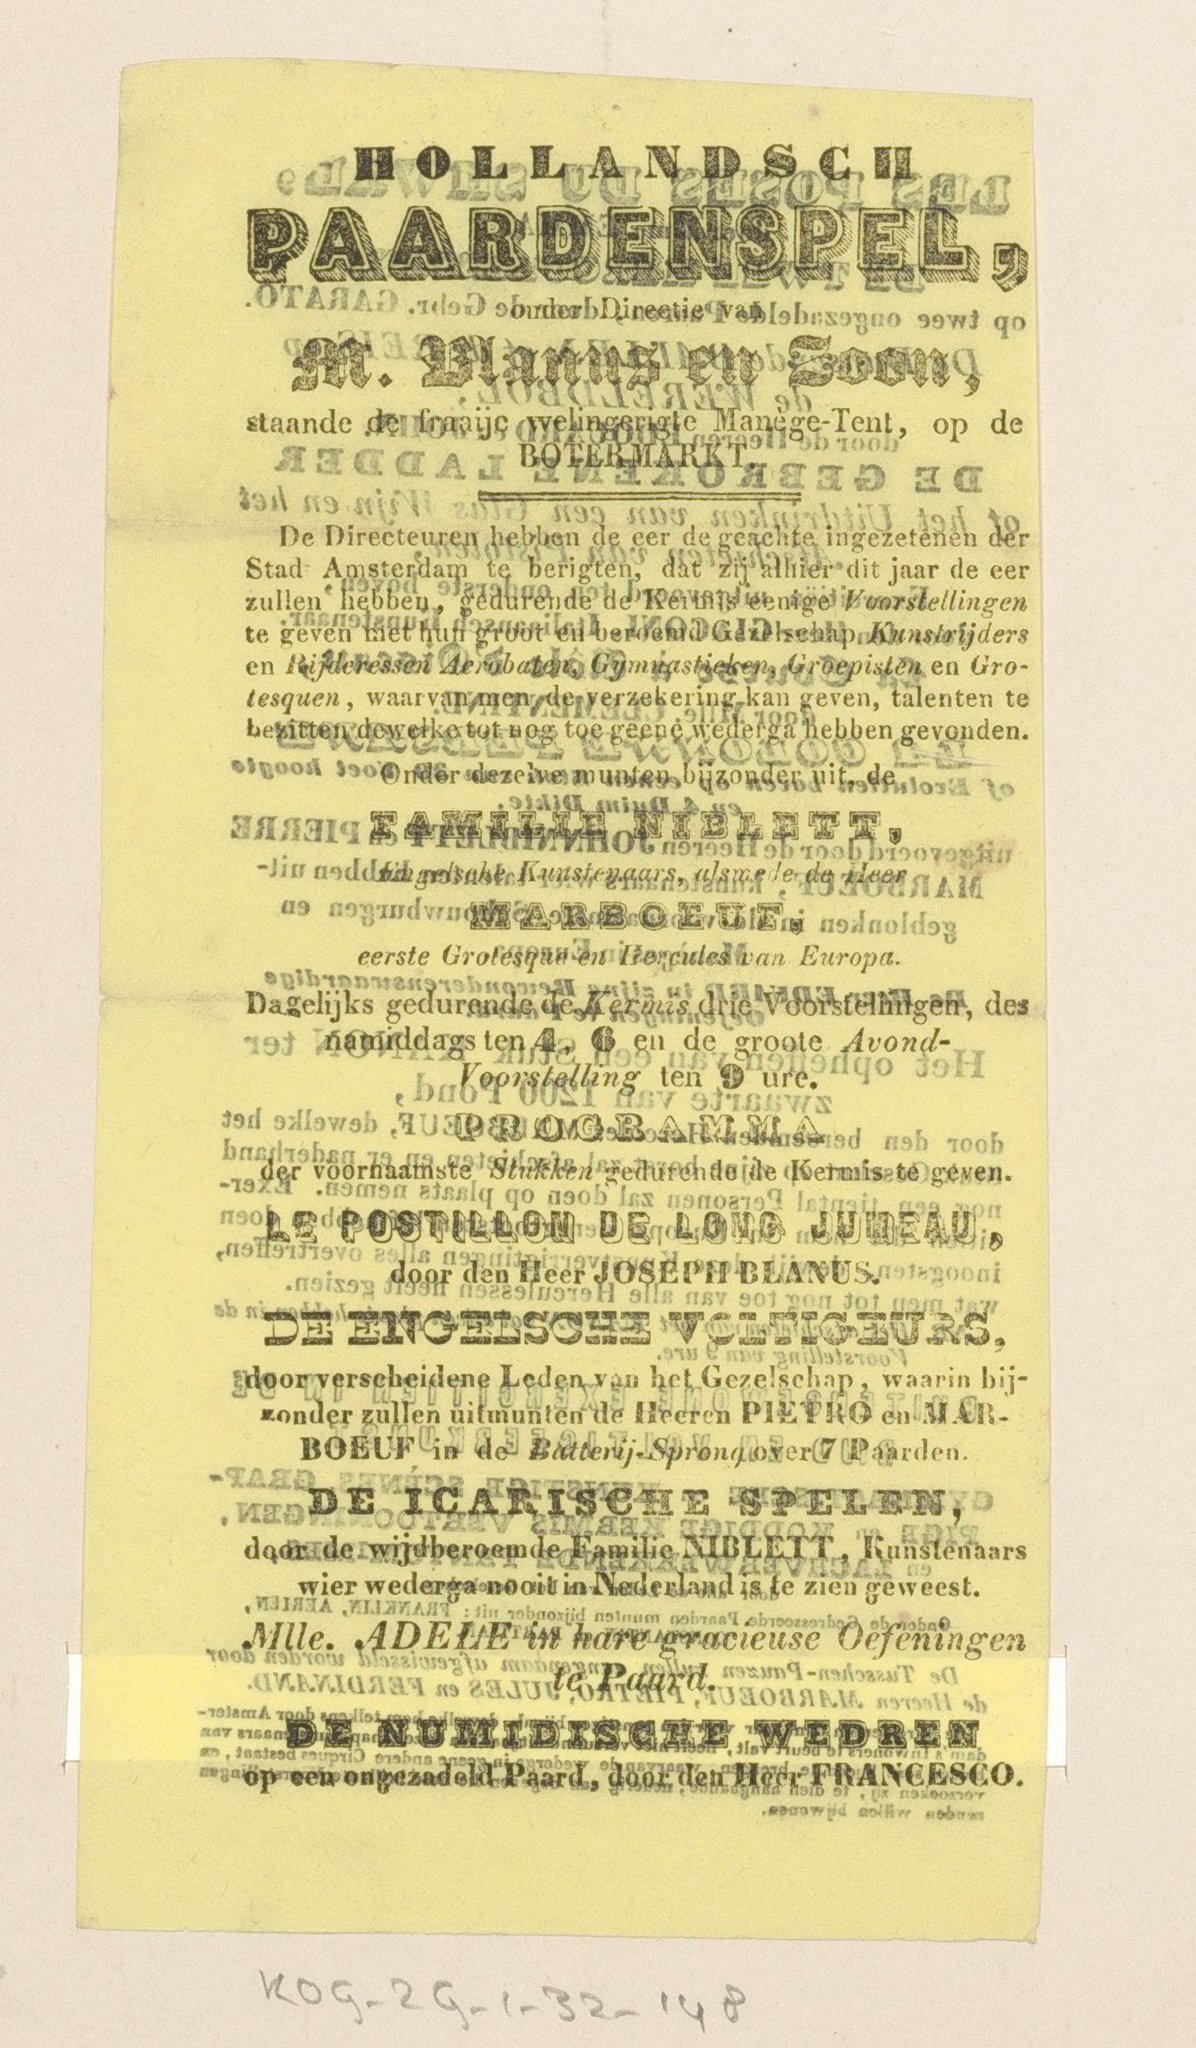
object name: programma, programmaboekje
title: Hollandsch Paardenspel, onder directie van M. Blanus en Zoon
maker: Anonymous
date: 1852-1856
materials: paper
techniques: letterpress printing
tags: pleasure fair and circus, horses (circus performance), amsterdam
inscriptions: collector's mark, collector's mark: Lugt 1641